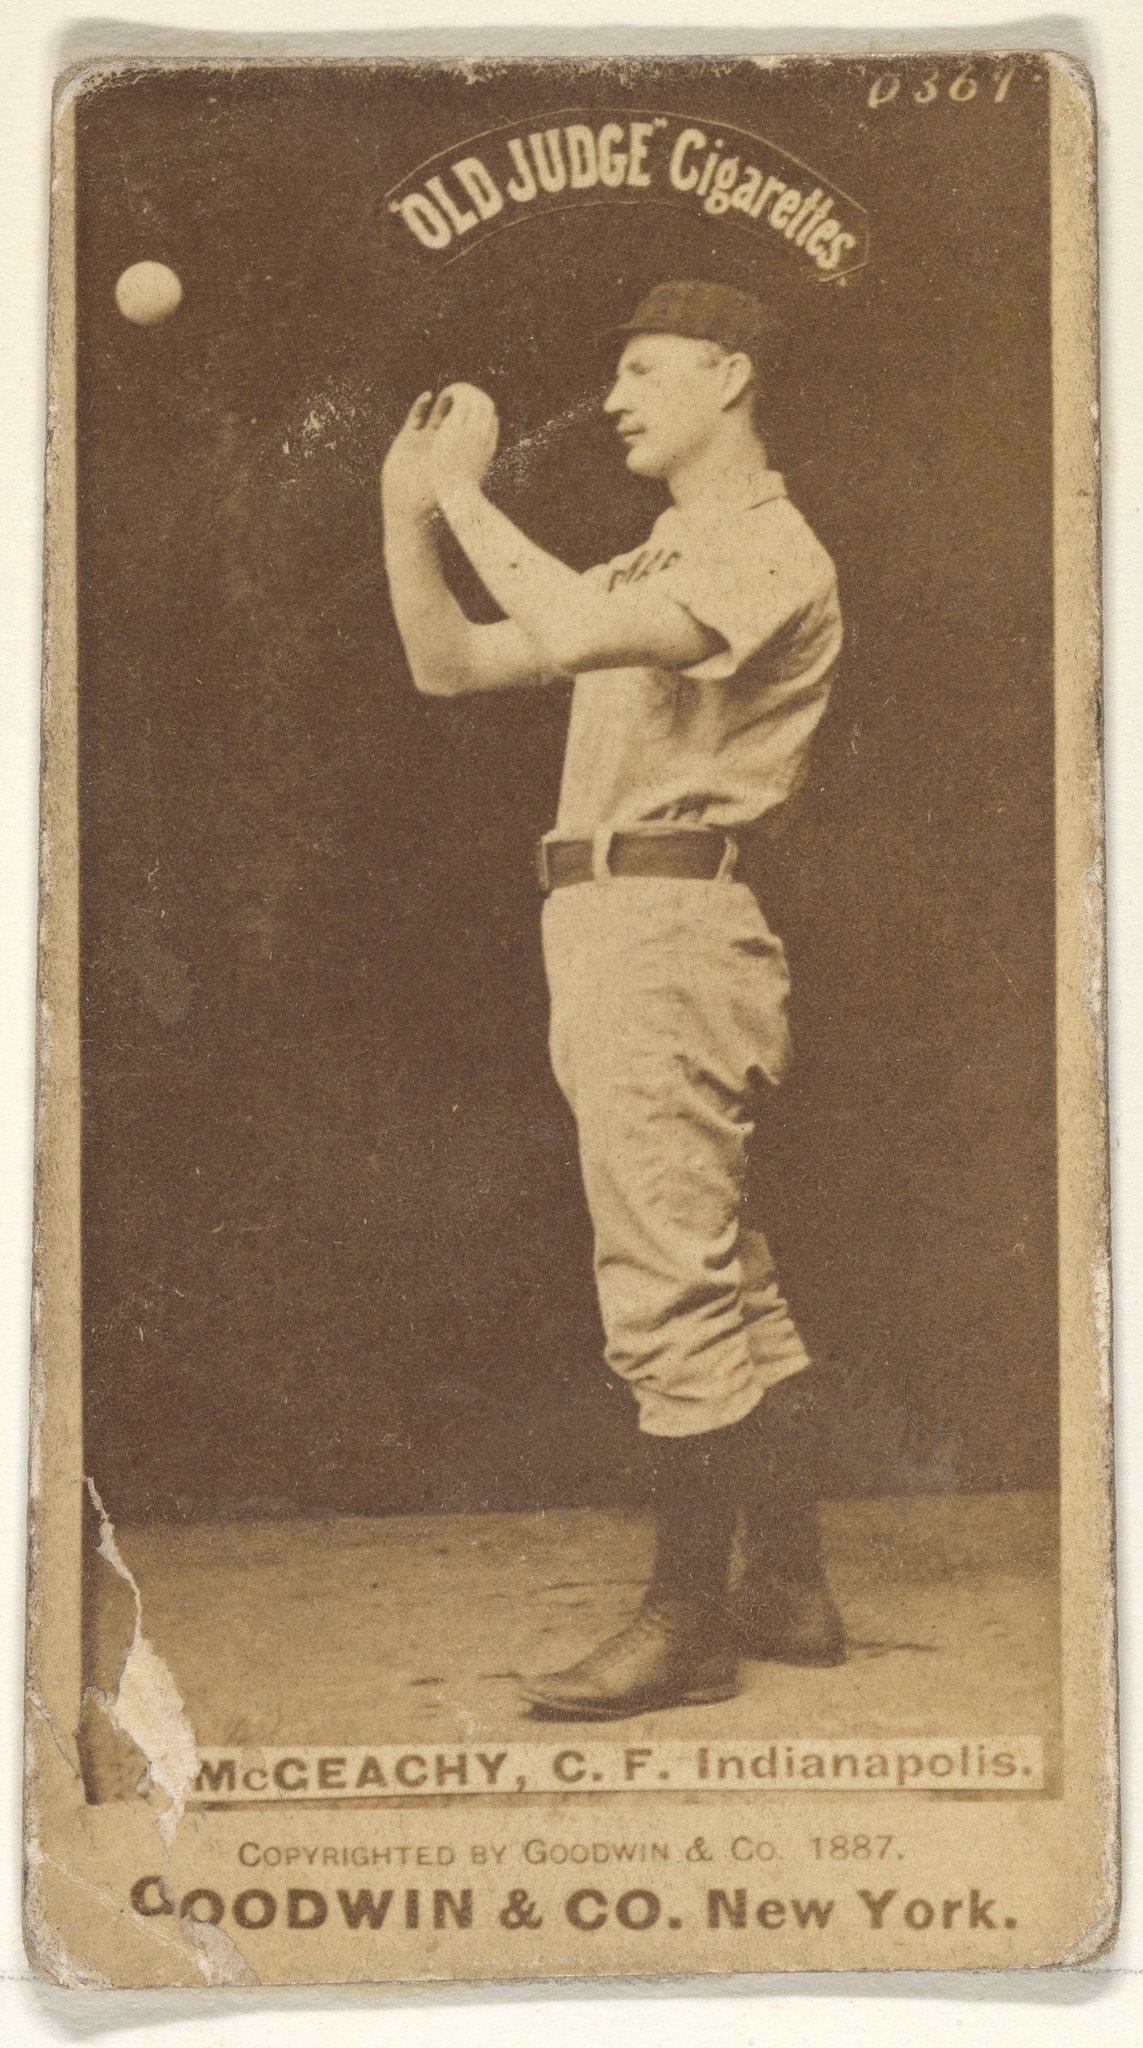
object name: baseball card, photograph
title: Jack McGeachey, Center Field, Indianapolis, from the Old Judge series (N172) for Old Judge Cigarettes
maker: goodwin & company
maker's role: publisher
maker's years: 1850-1950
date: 1889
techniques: albumen silver print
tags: men,portraits,baseball,athletes